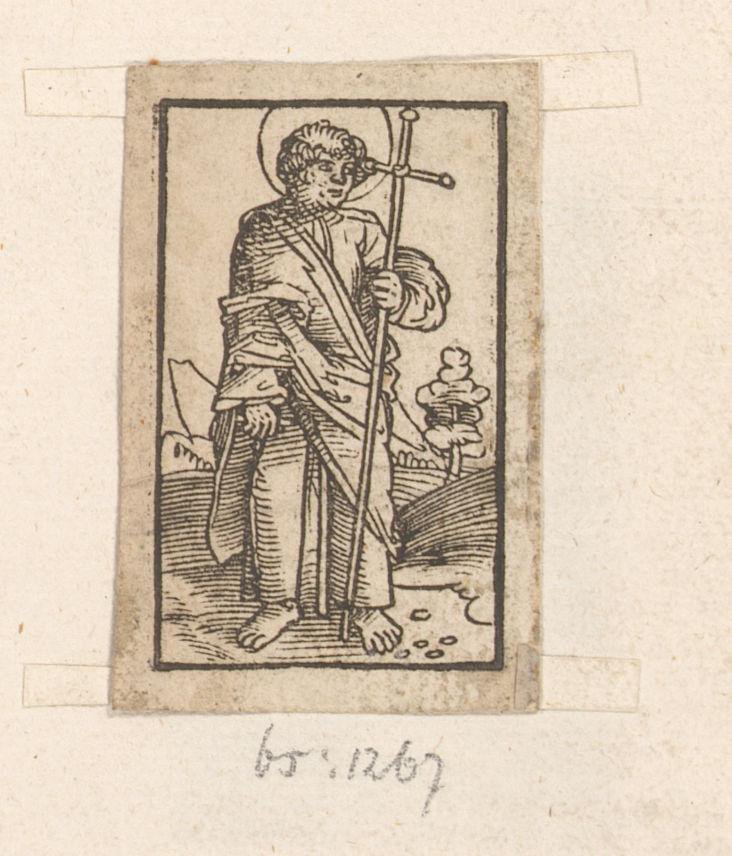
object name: print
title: Filippus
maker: Anonymous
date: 1500-1550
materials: paper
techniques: woodcut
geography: germany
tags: the apostle philip; possible attributes: book, cross, dish with snake, lance, scroll, stone, sword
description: De apostel Filippus met een kruis in zijn linkerhand. Prent maakt deel uit van een album.